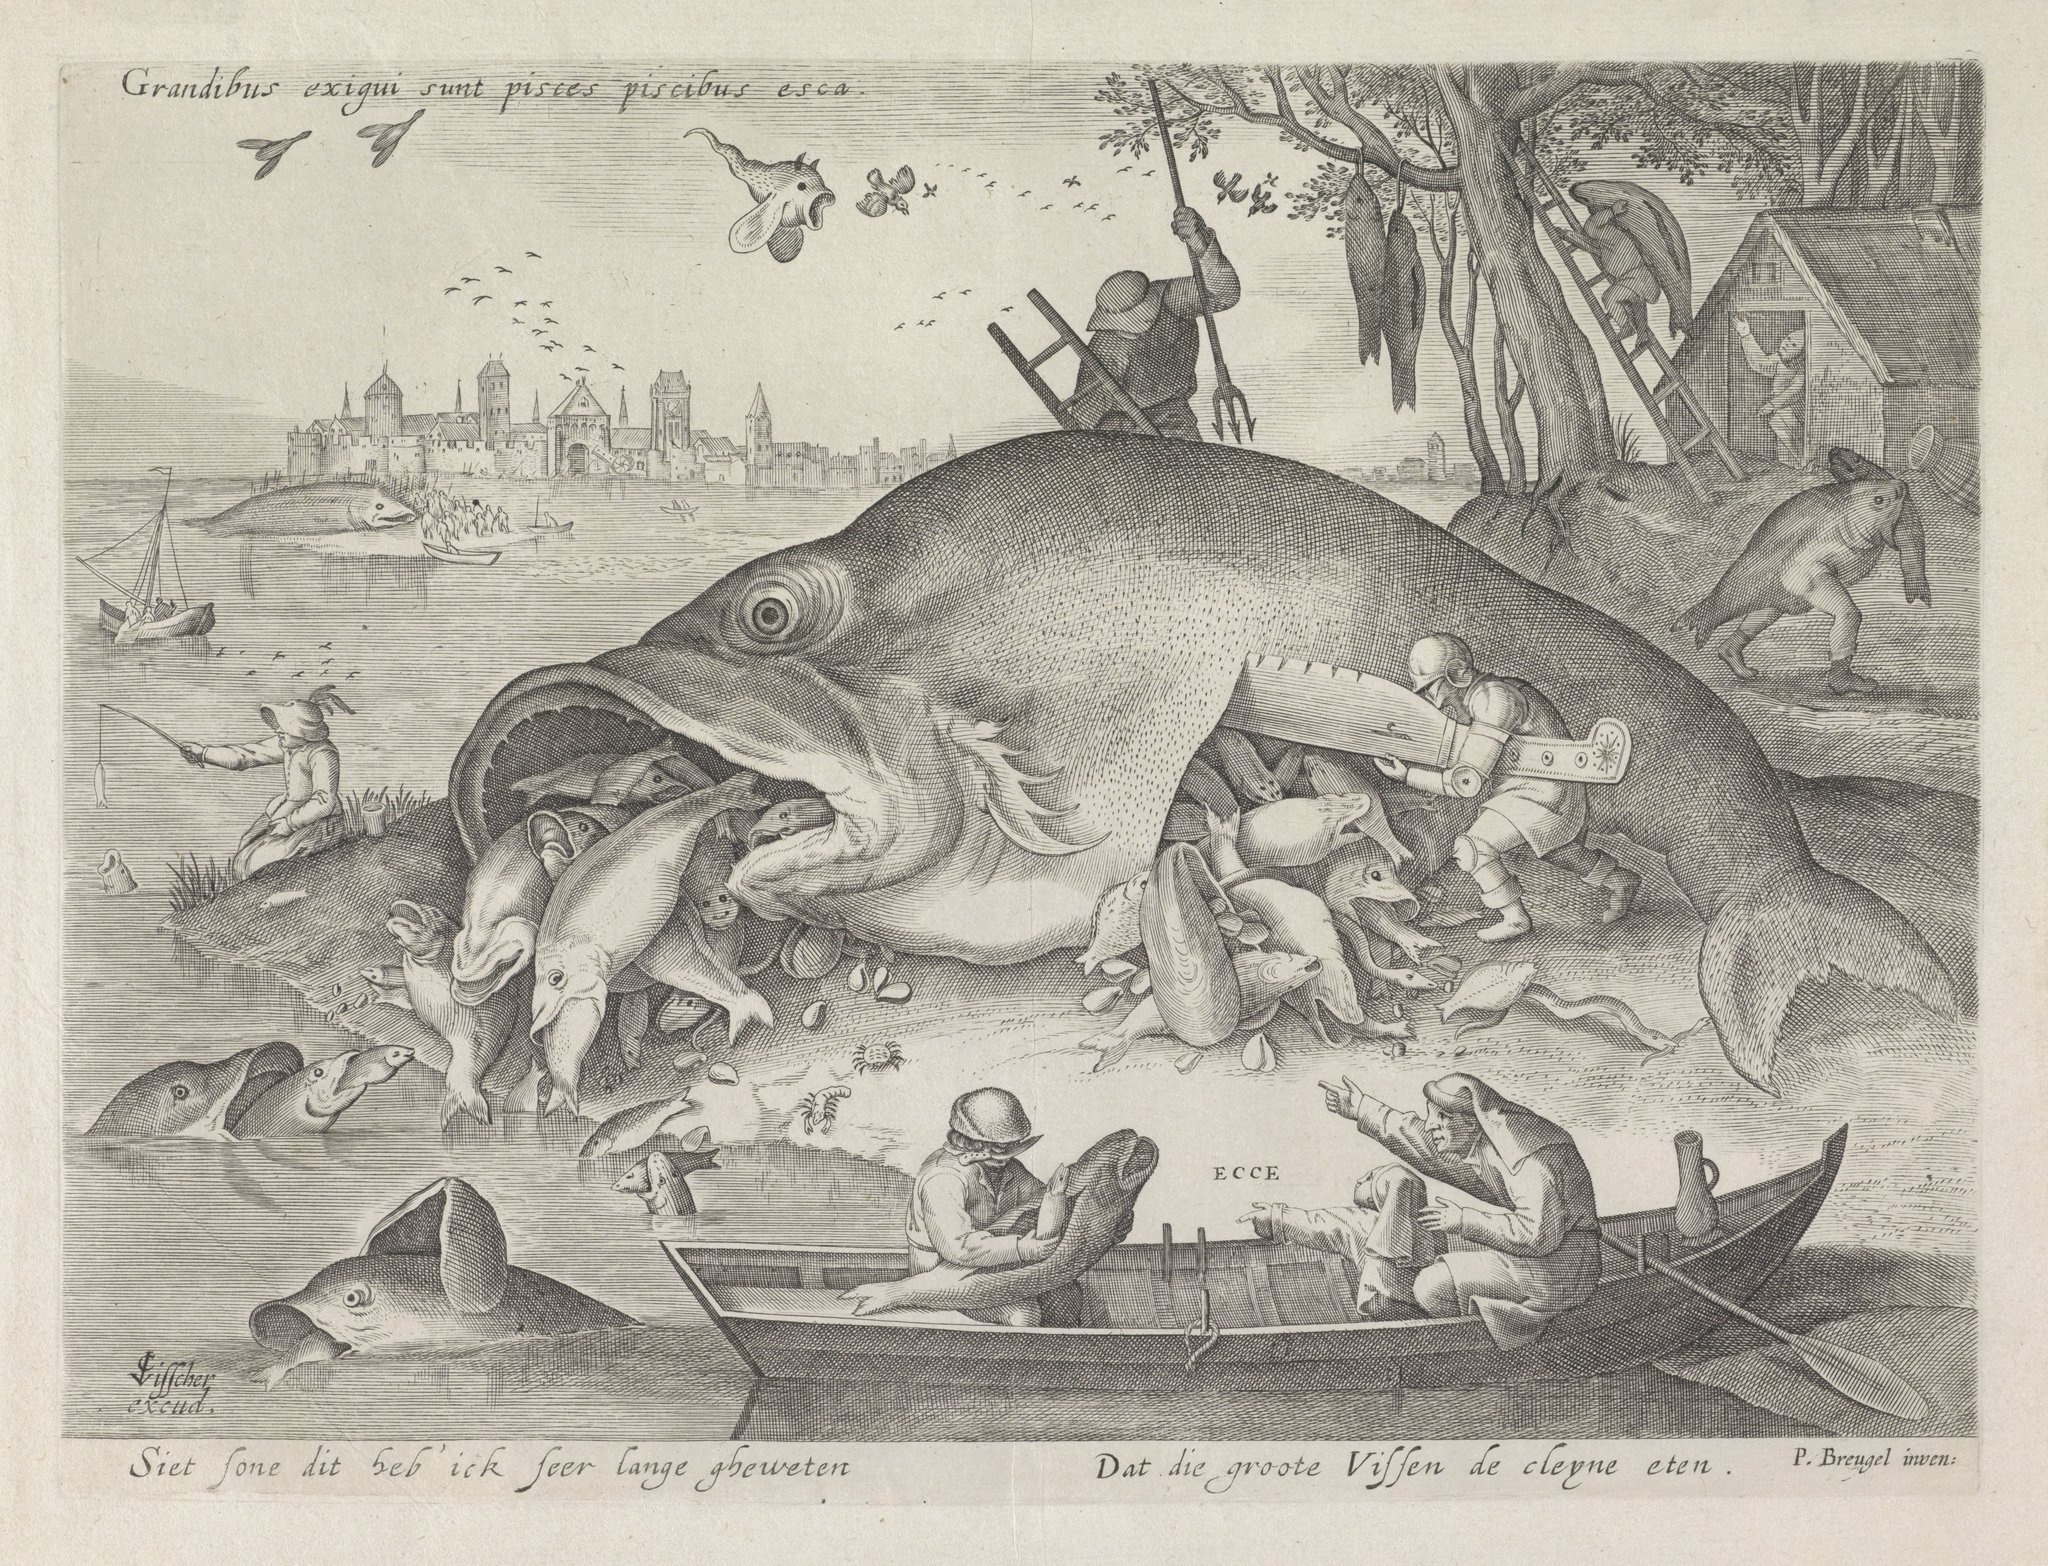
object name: print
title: Grote vissen eten de kleine vissen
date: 1601-1652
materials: paper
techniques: engraving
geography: amsterdam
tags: monsters larger than normal, fishes, proverbs, sayings, etc.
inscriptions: collector's mark: Lugt 2228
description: De grote vissen eten de kleine vissen. Een grote vis die gevangen op de oever ligt wordt door een mannetje met een mes opengesneden waardoor vele kleine vissen en schelpen uit de buik en en bek tevoorschijn komen. Op de voorgrond een roeibootje waarin een vader zijn zoon op het schouwspel wijst en een visser. Onder de voorstelling een regel in het Latijn en een regel in het Nederlands.